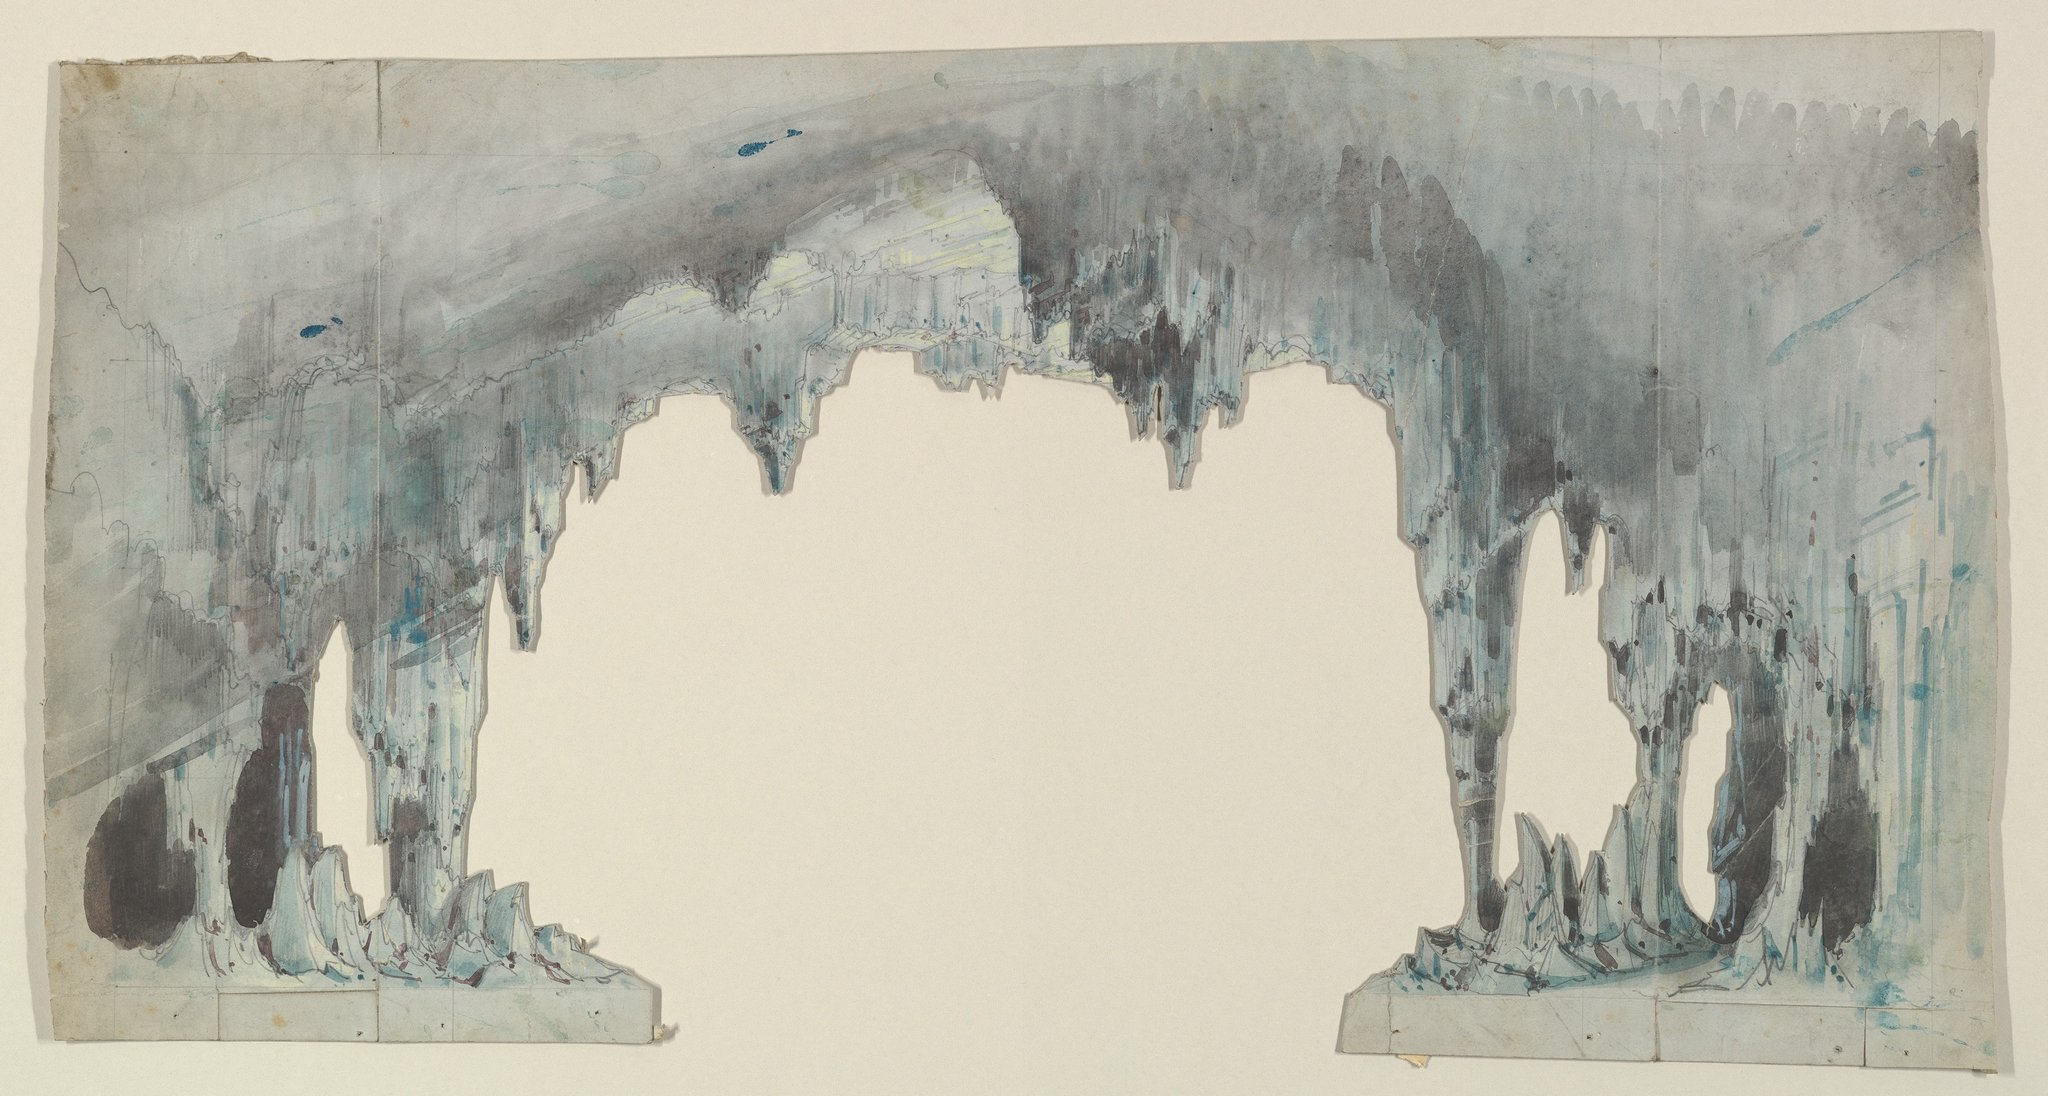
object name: drawing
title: Design for a Stage Set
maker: eugène cicéri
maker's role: artist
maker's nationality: french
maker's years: 1813-1890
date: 1830-1890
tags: stage design